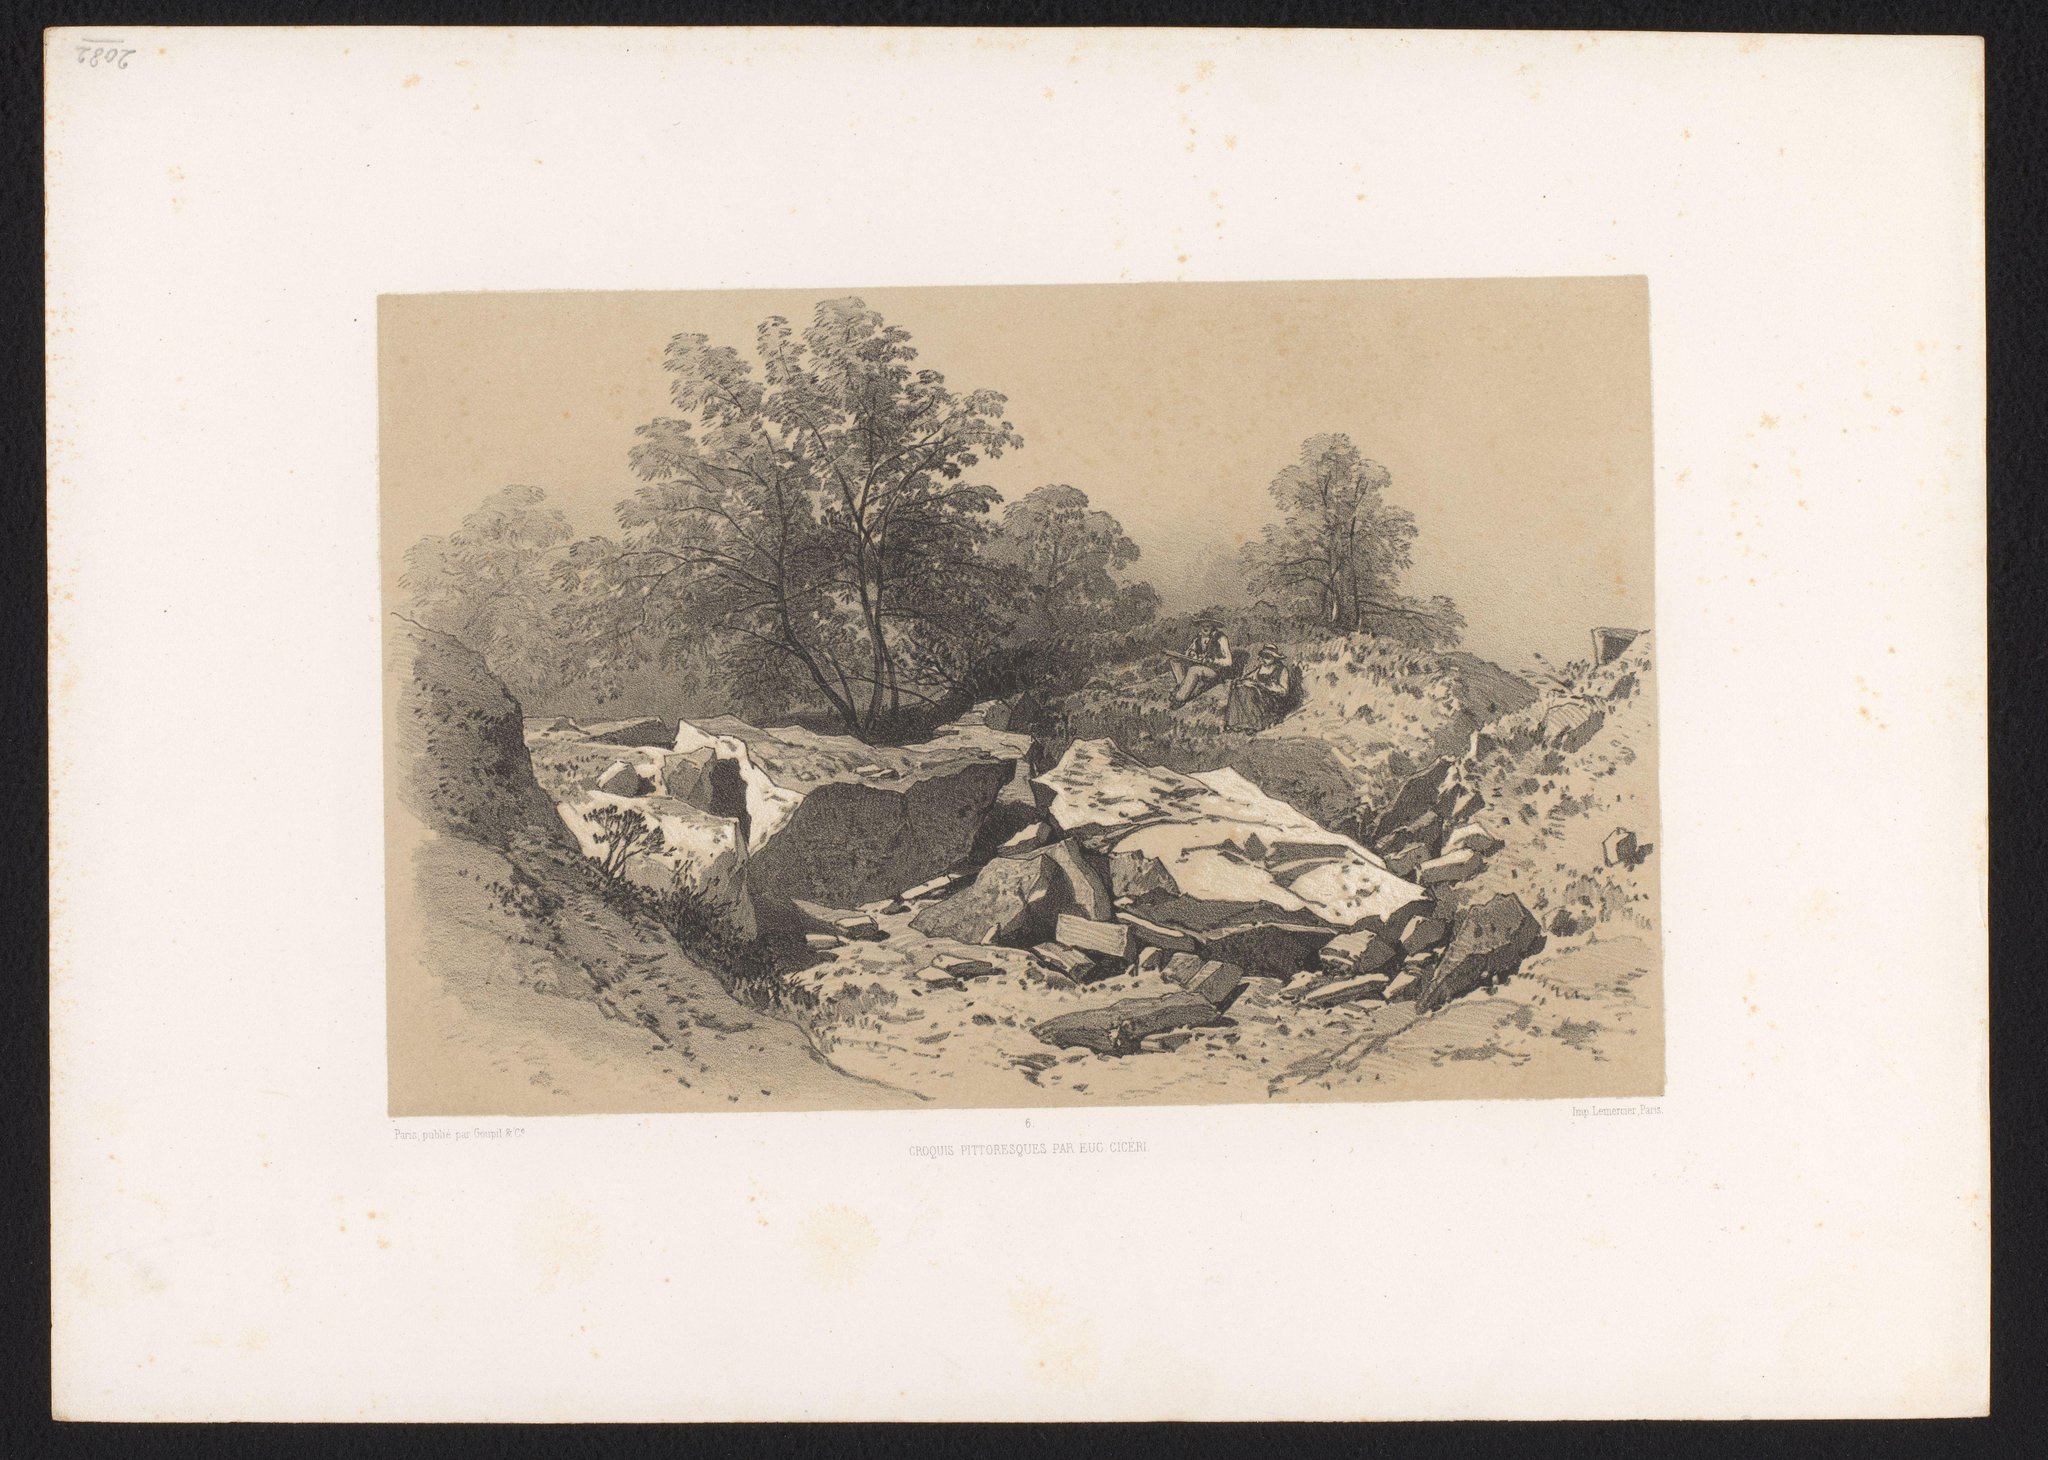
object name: print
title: Rotsblokken met tekenaar en vrouw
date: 1854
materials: paper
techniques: tone lithography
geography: paris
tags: draughtsman at work - cc - out of doors, rocks (+ landscape with figures, staffage)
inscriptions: number: ‘2082’, check stamp: Lugt 1090